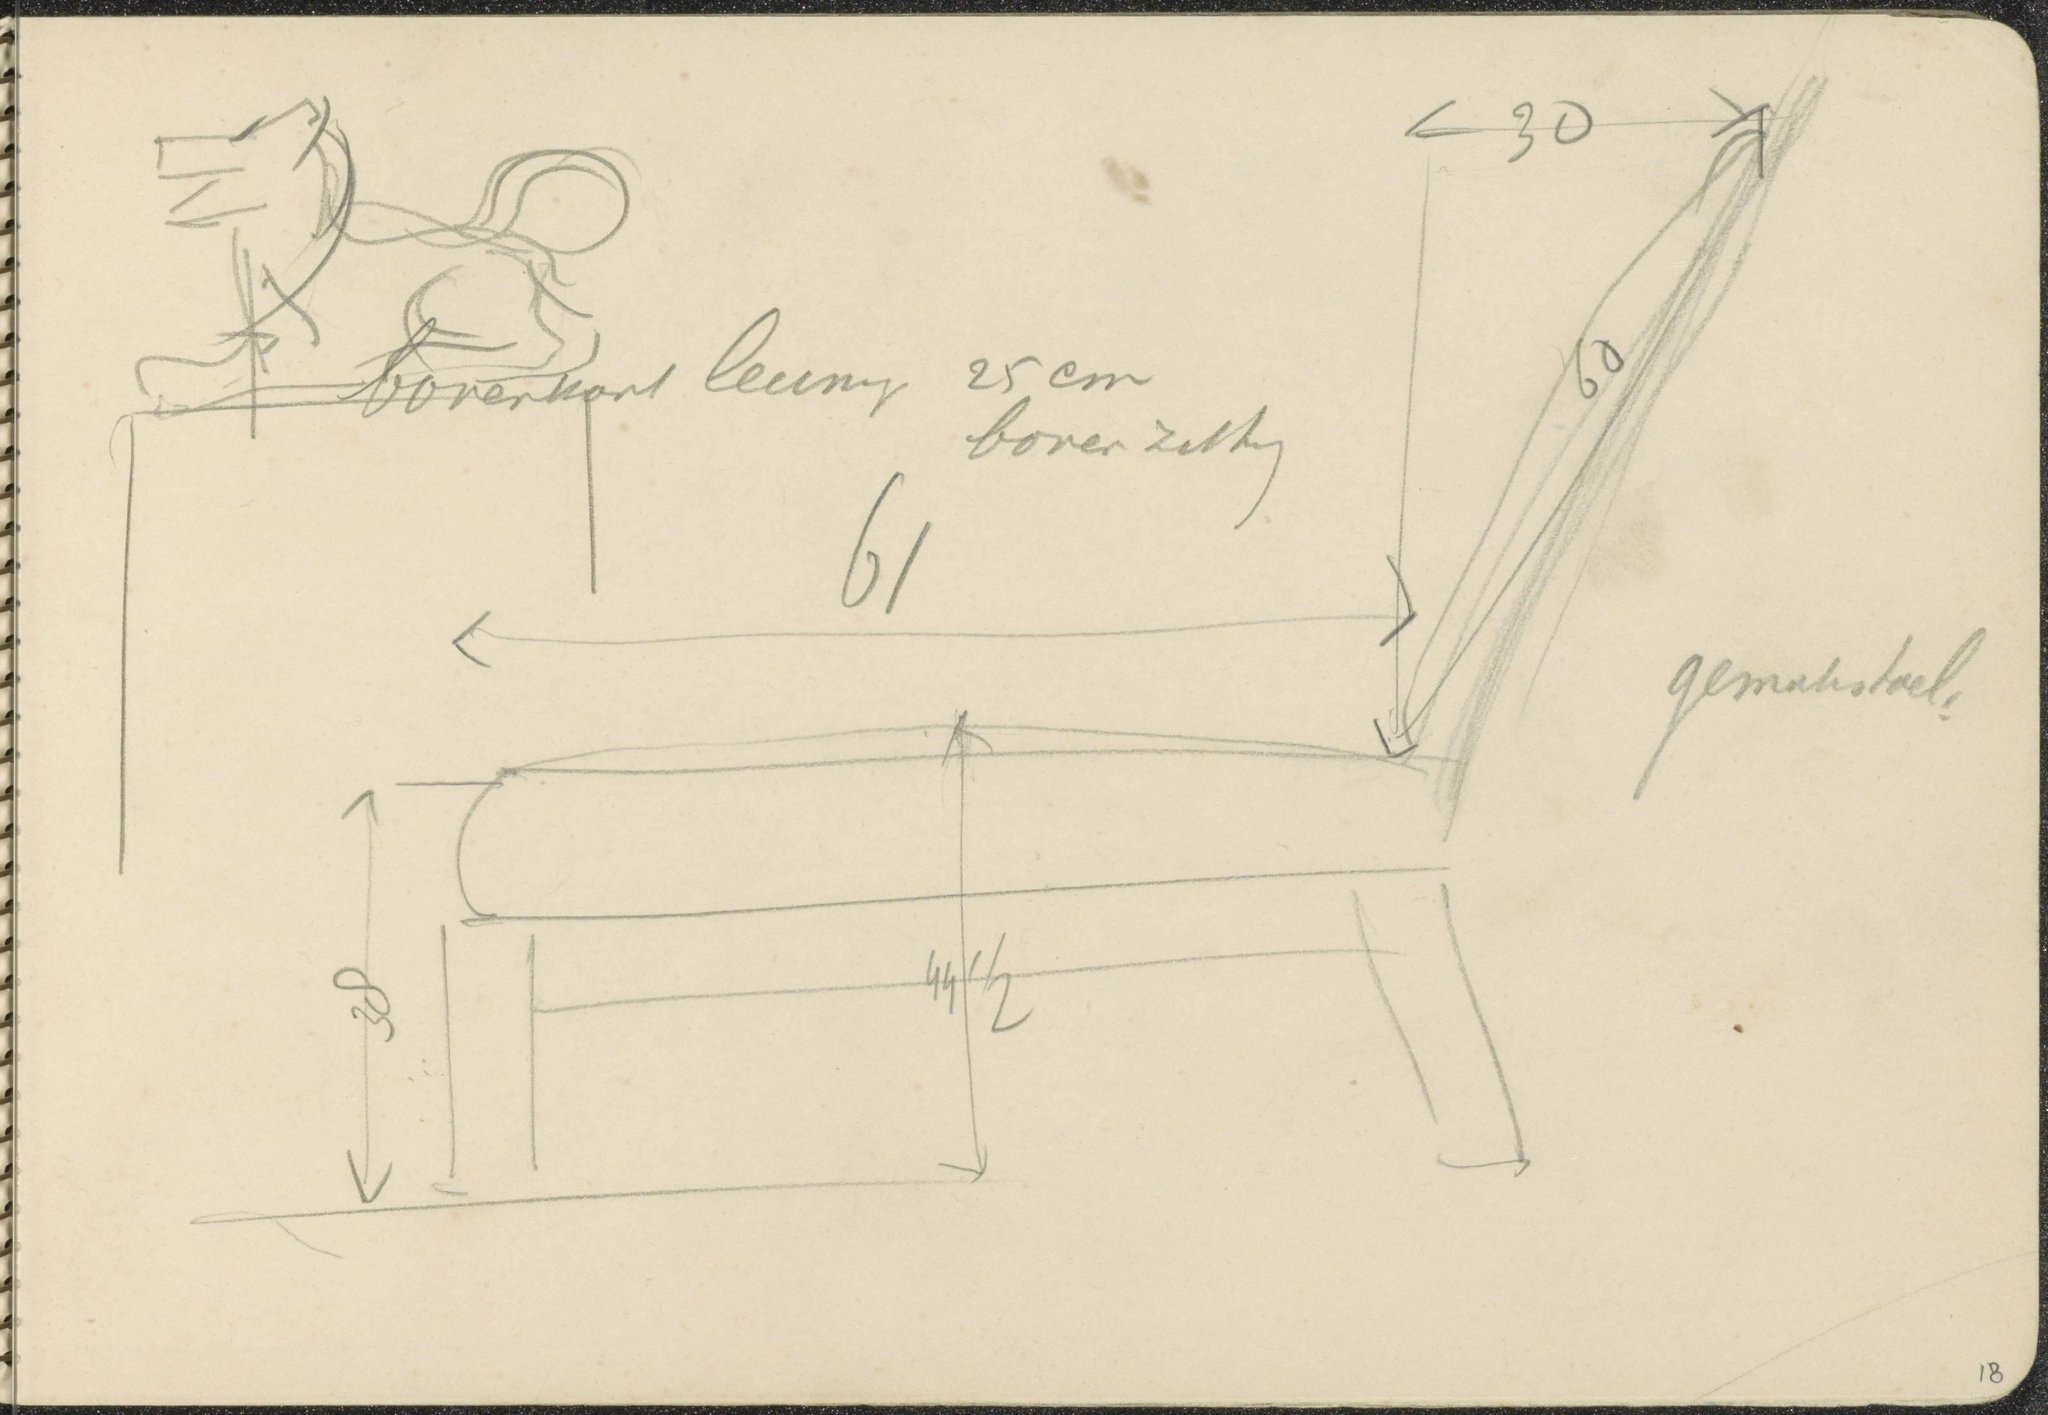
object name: sketchbook leaf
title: Ontwerp voor een leunstoel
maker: carel adolph lion cachet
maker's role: draughtsman, print maker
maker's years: 1864-1945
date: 1934-1943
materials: paper, pencil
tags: armchair, seat, sculpture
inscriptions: annotation: ‘bovenkant leeuw 25 cm/ boven zit hij’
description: Tevens eens studie van een beeldhouwwerk van een liggende leeuw op een sokkel. Blad 18 recto uit een schetsboek met 19 bladen.